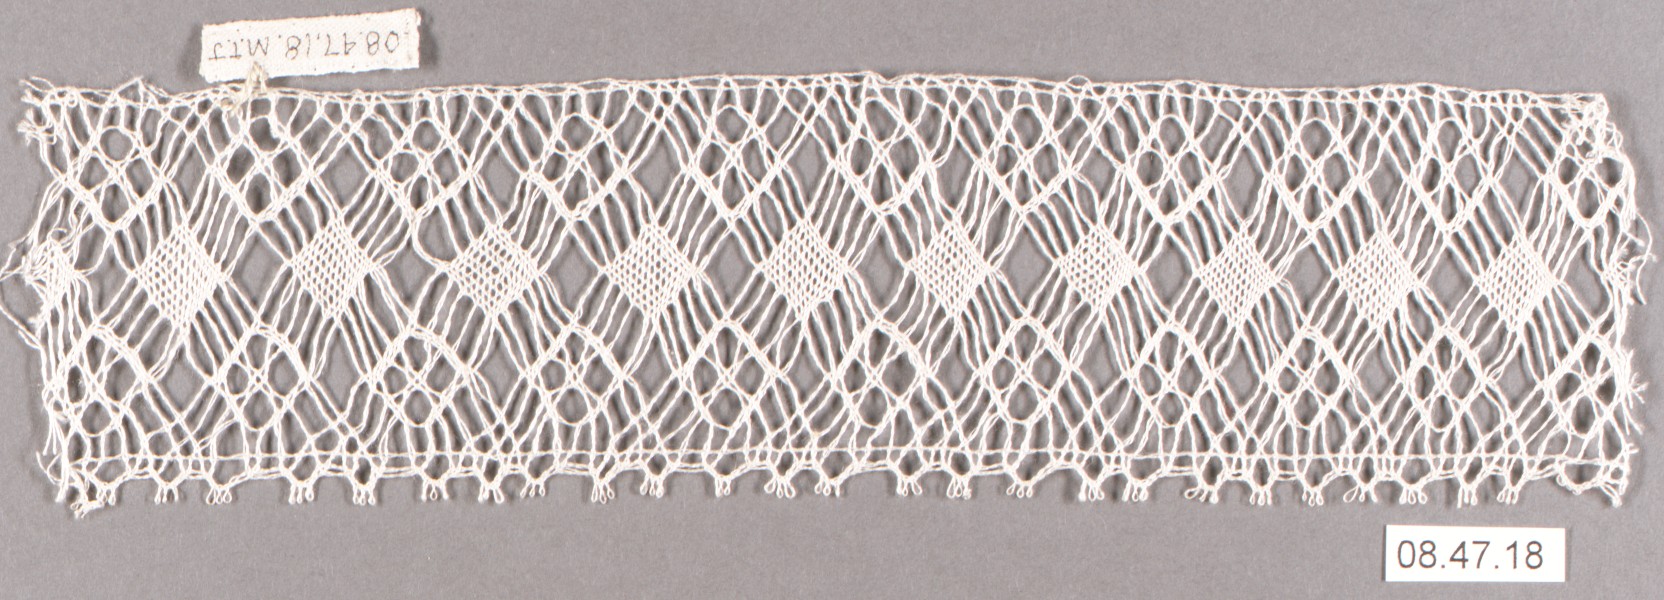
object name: fragment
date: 1801-1900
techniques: lace